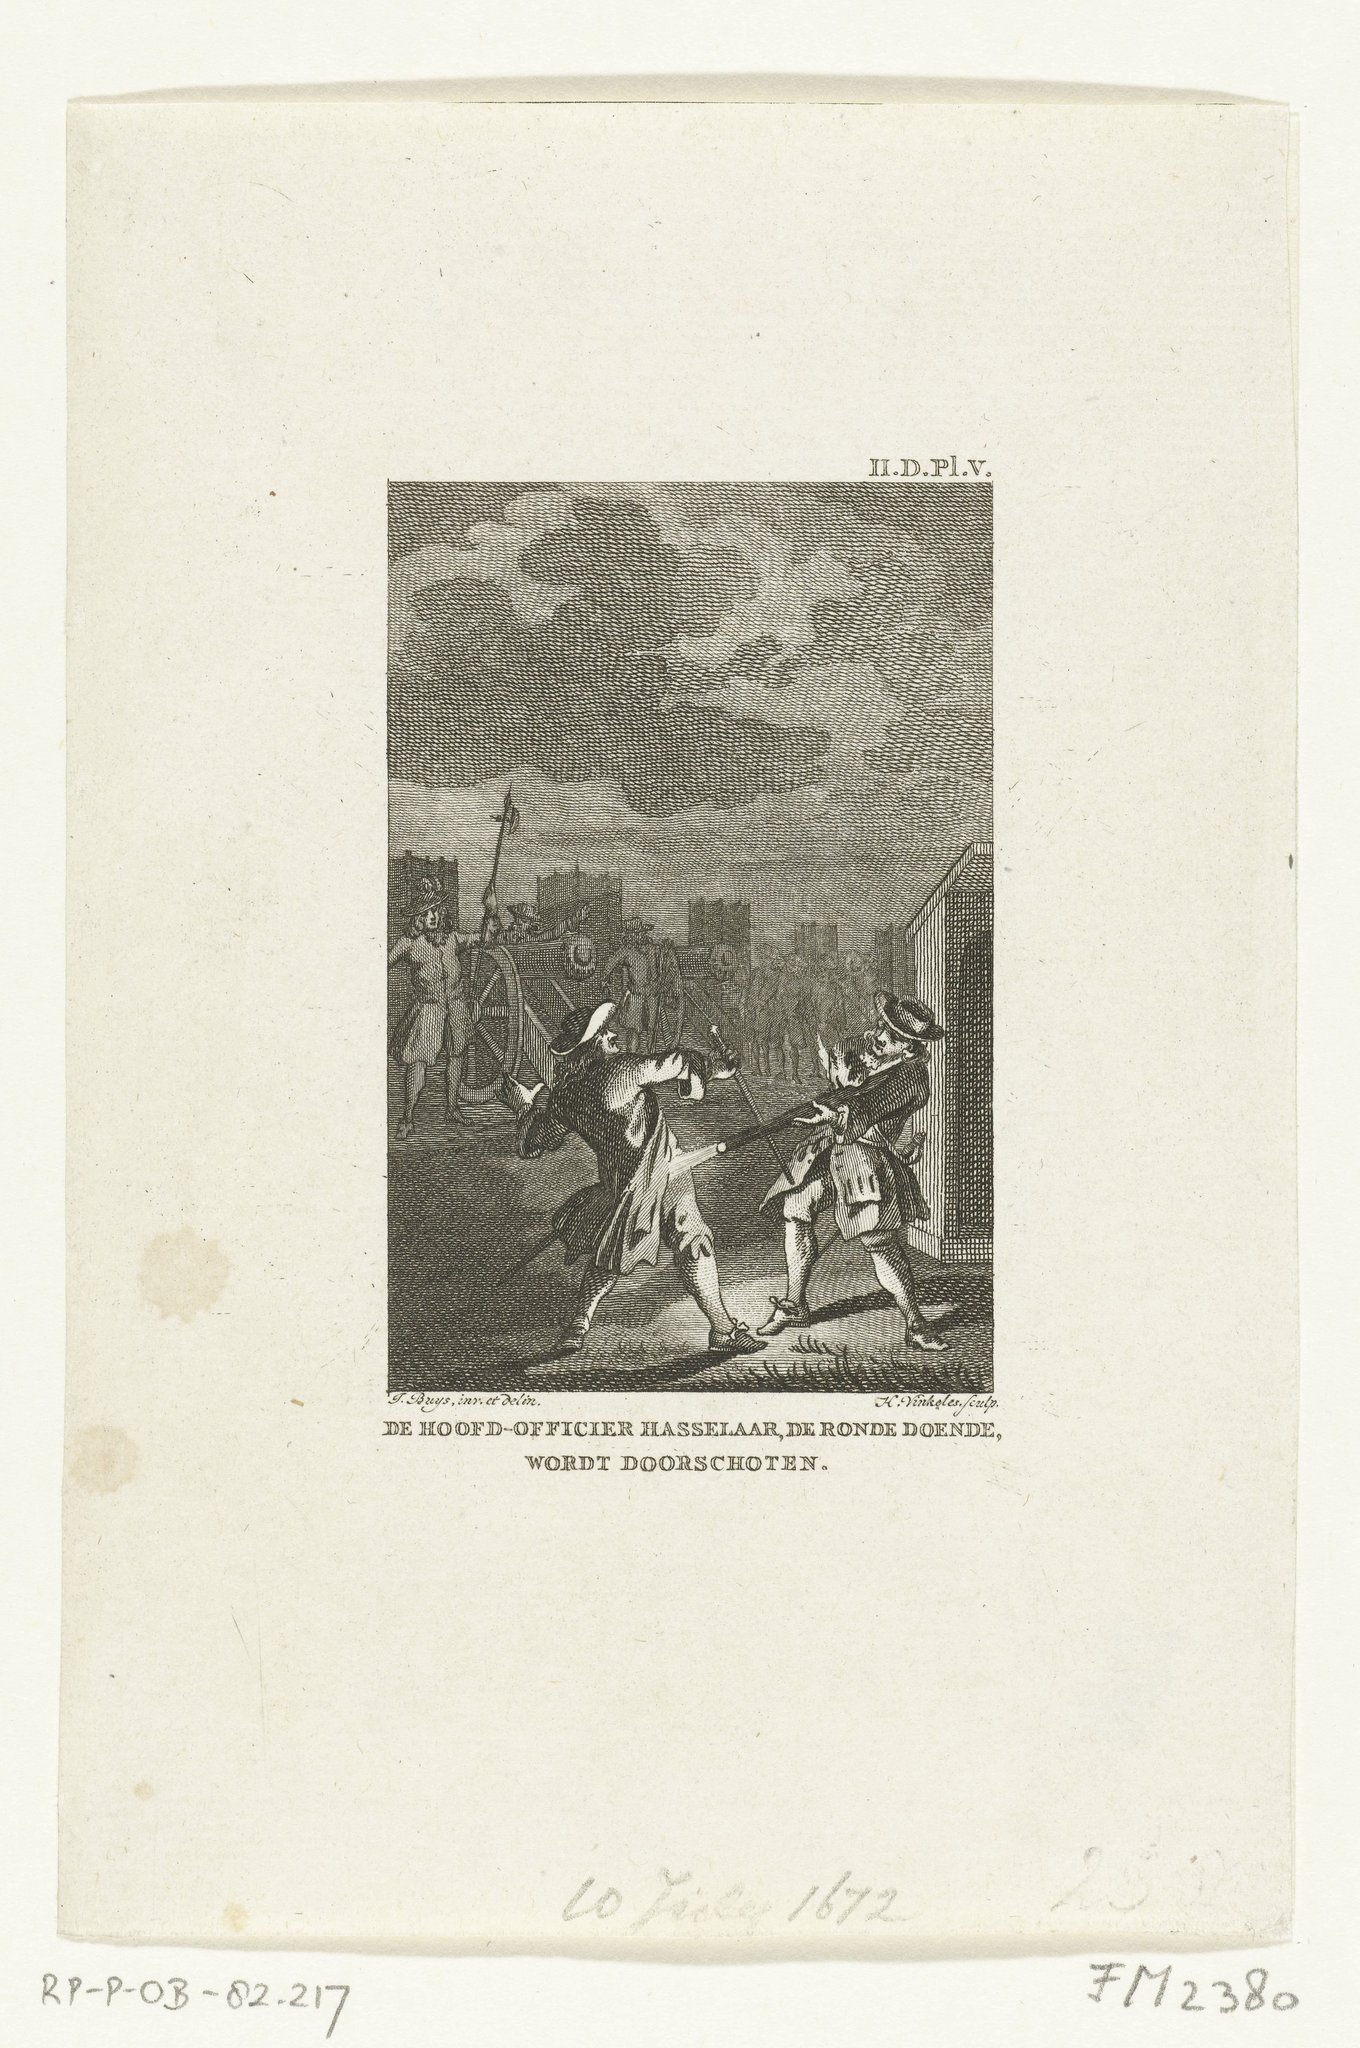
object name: print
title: De hoofd-officier Hasselaar, de ronde doende, wordt doorschoten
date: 1786-1792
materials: paper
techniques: etching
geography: northern netherlands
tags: mayor, violent death, being killed; being mishandled and maltreated; seeking death, amsterdam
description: Hoofdofficier (burgemeester) Gerard Hasselaar te Amsterdam per ongeluk door een schildwacht neergeschoten, in de nacht van 28 op 29 juni 1672, overleden op 11 juni 1673.